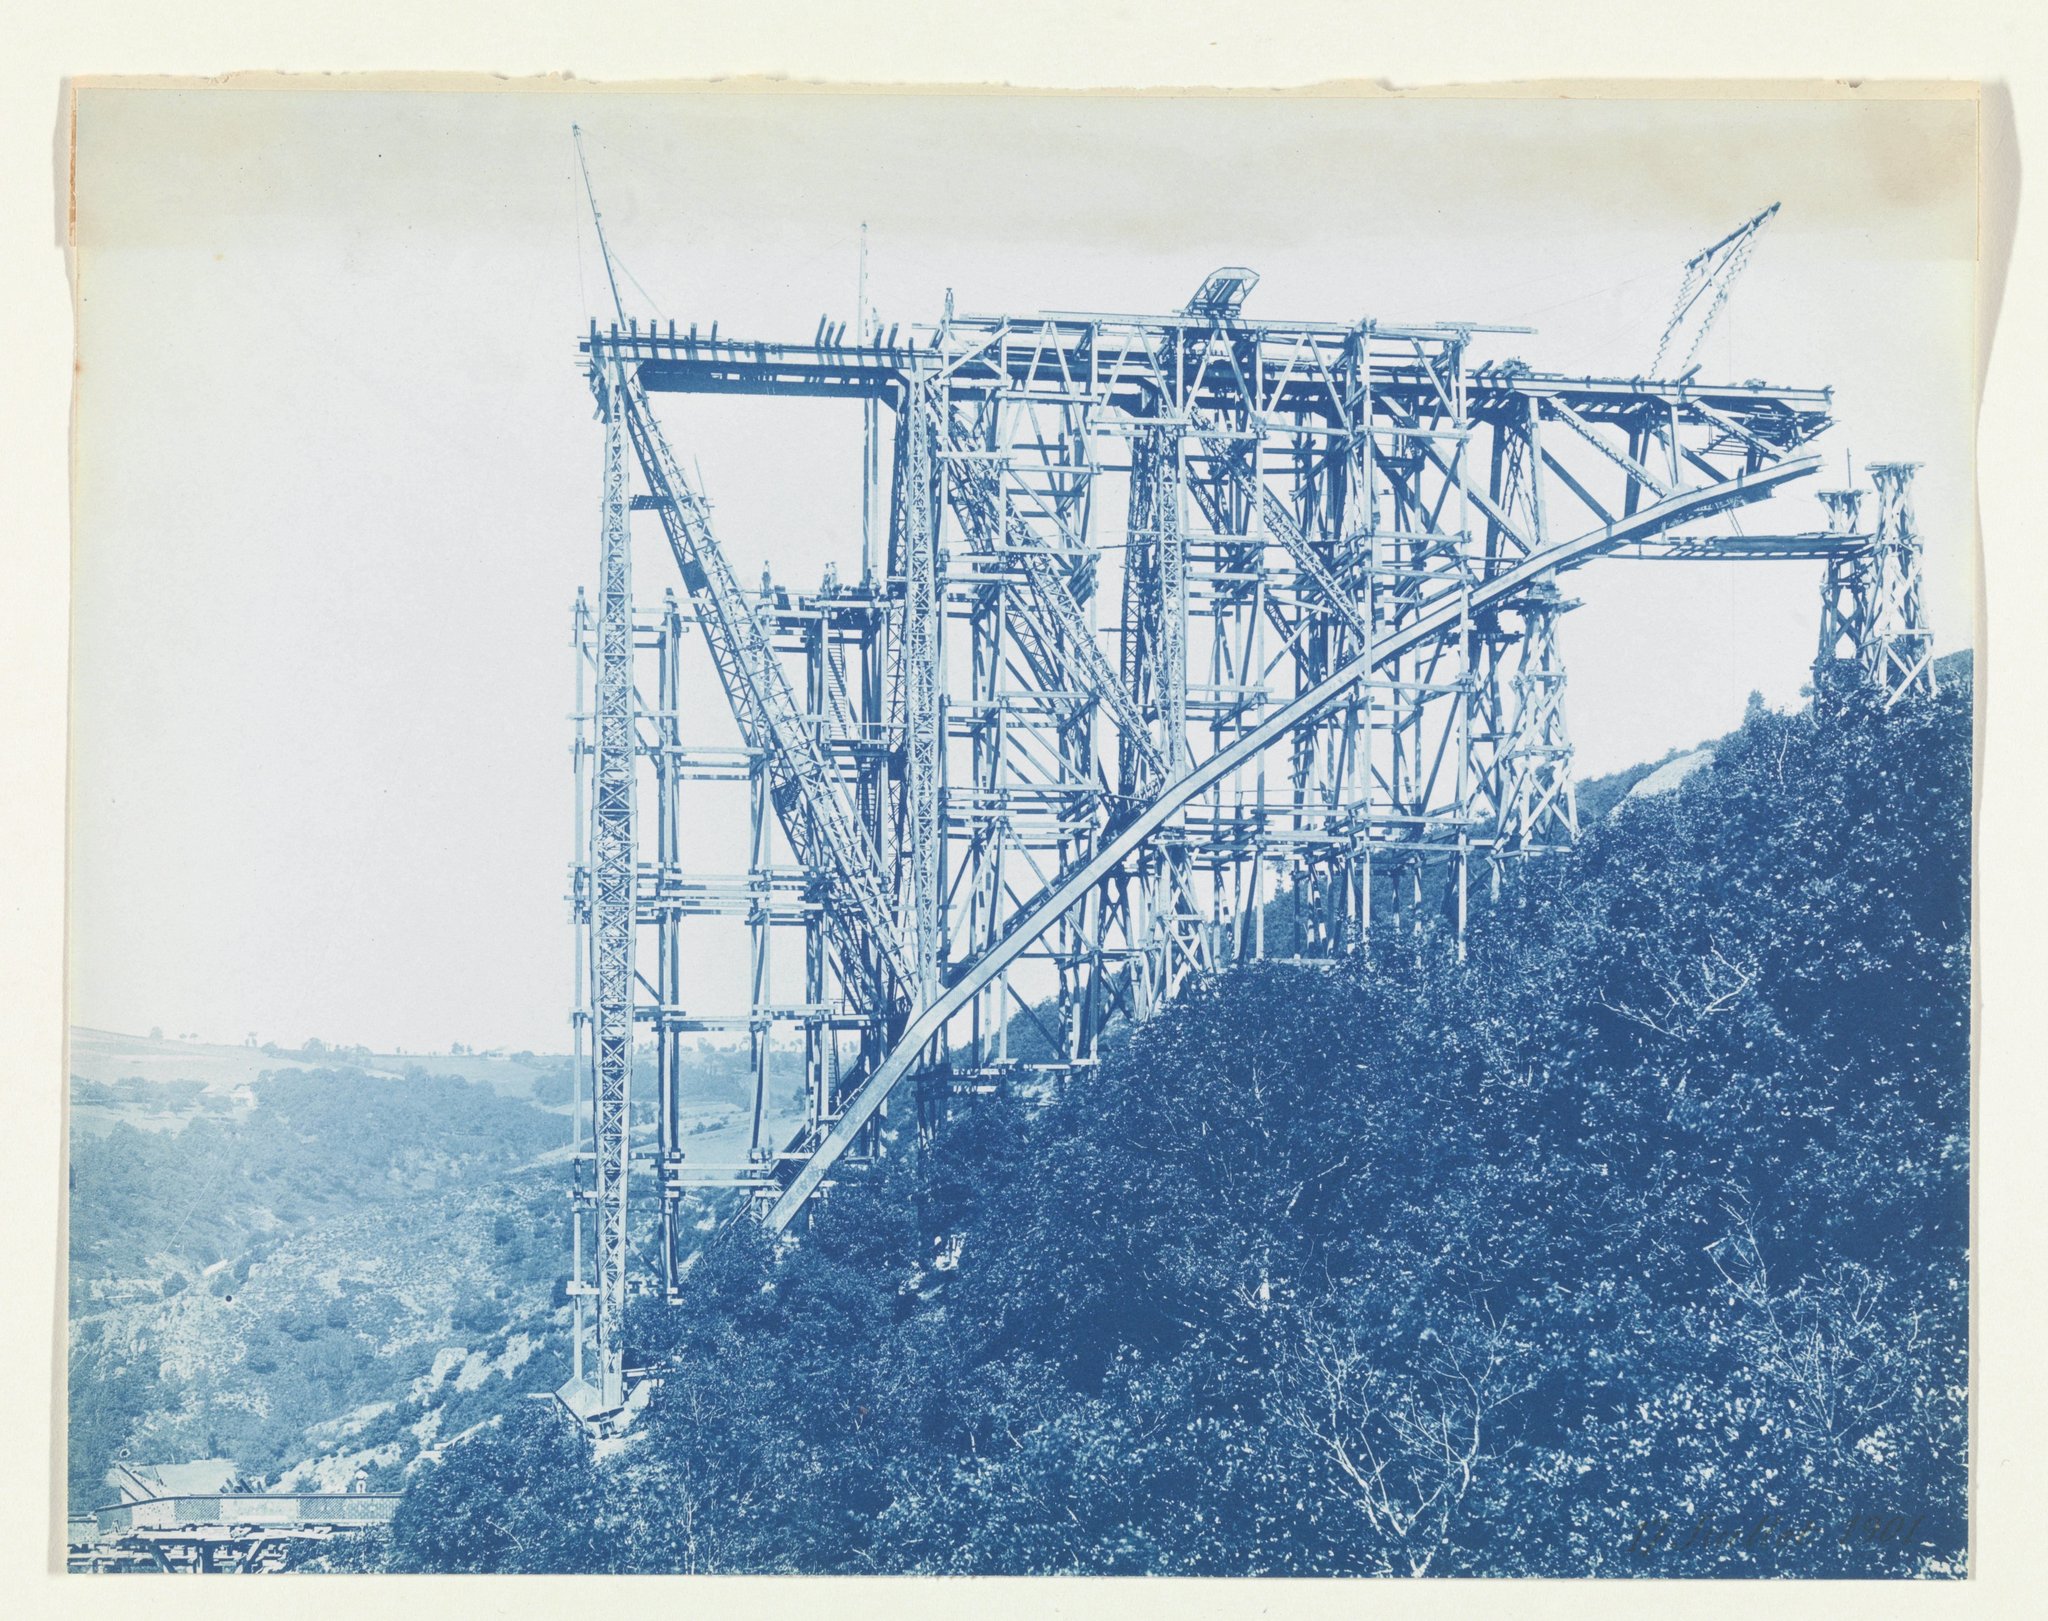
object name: photograph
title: Aanleg van het Viaur Viaduct in Frankrijk door de Societé de Construction des Battignolles, 17 juli 1901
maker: Anonymous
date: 1901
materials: photographic support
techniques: cyanotype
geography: france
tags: viaduct, making the overground structures (~ building activities)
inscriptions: date